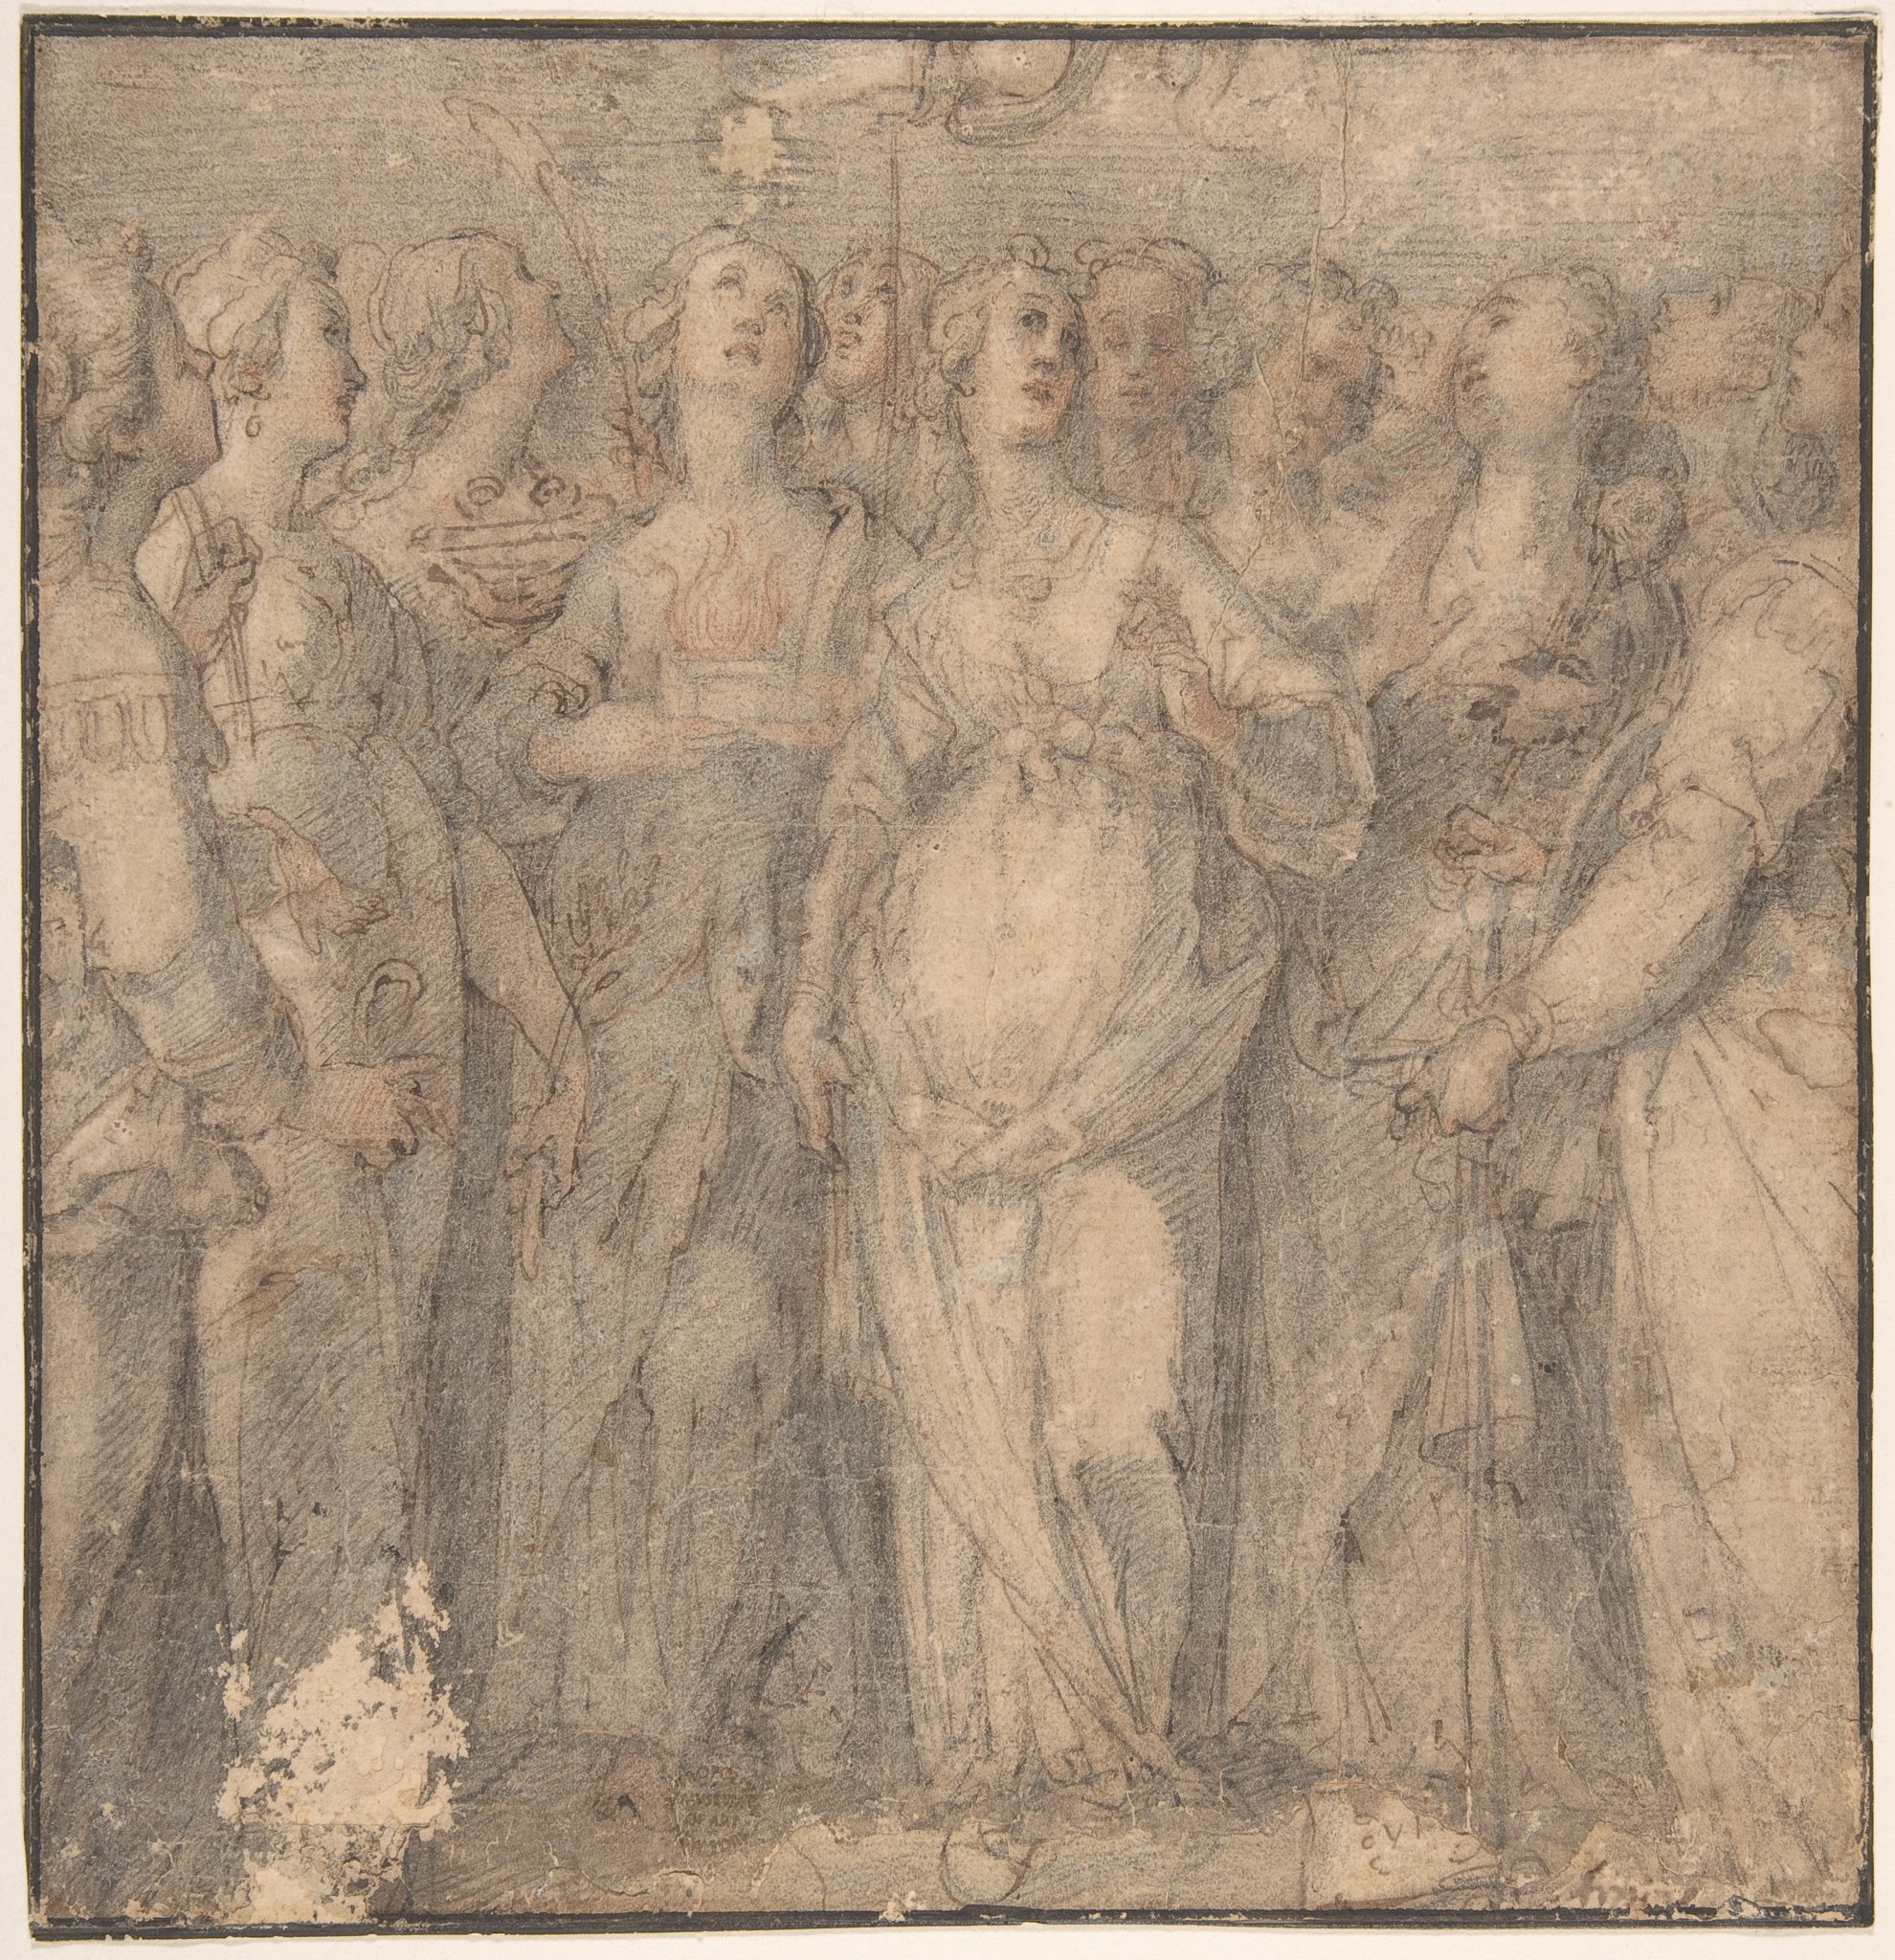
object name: drawing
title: Group of Standing Female Saints (the Holy Virgins)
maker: anonymous, italian, 16th to 17th century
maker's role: artist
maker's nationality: italian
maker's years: 1500-1700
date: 1500-1700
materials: chalk, ink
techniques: pen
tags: women,saints